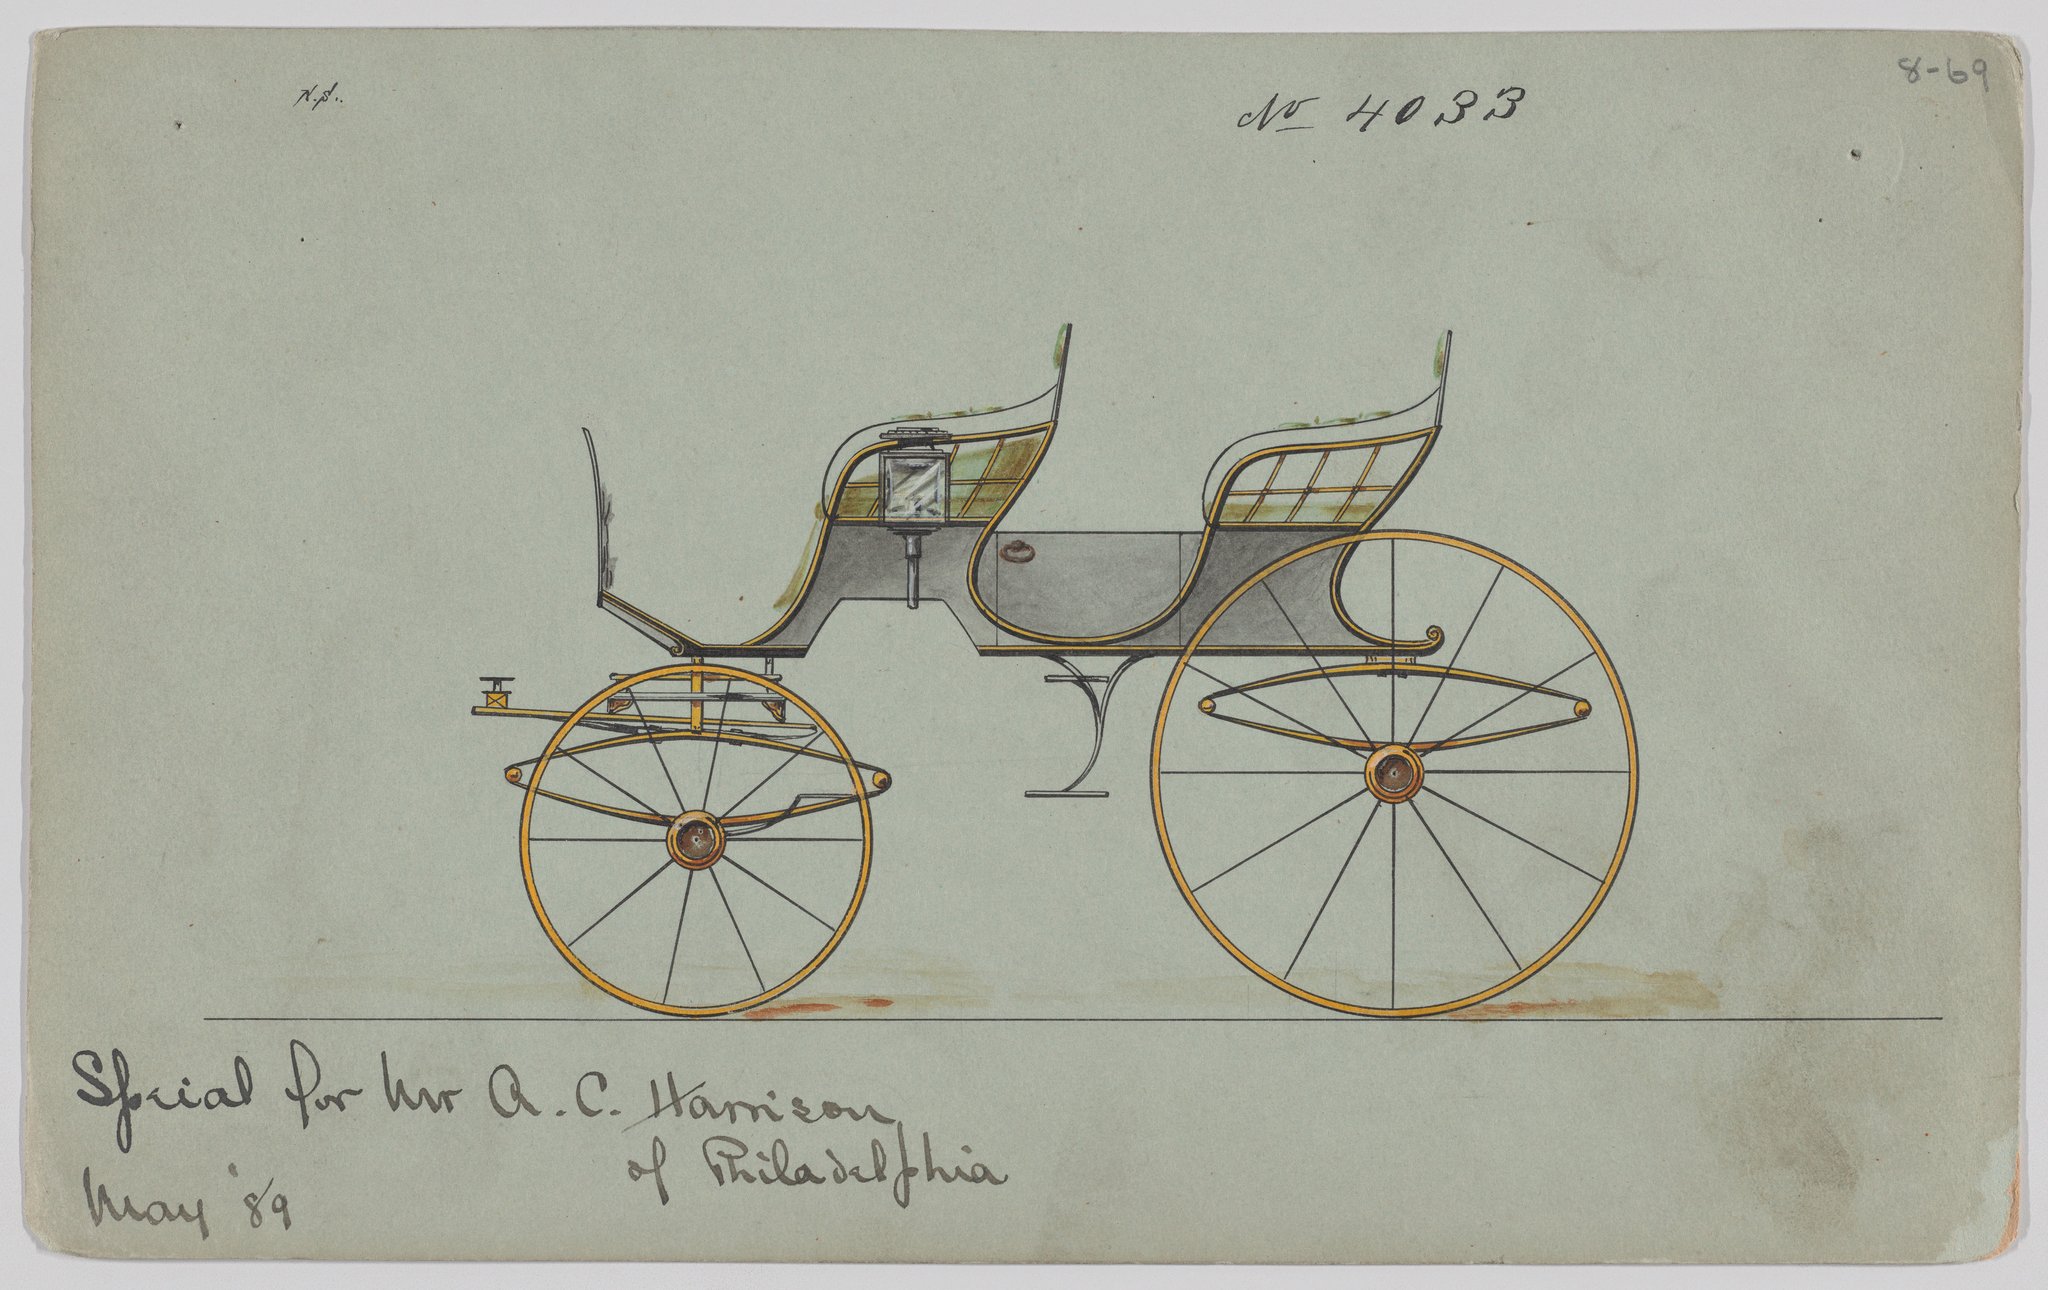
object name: drawing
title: Design for 4 seat Phaeton, no top, no. 4033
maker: brewster & co.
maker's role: manufacturer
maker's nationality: american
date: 1889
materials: gouache, ink, watercolor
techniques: pen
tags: carriages